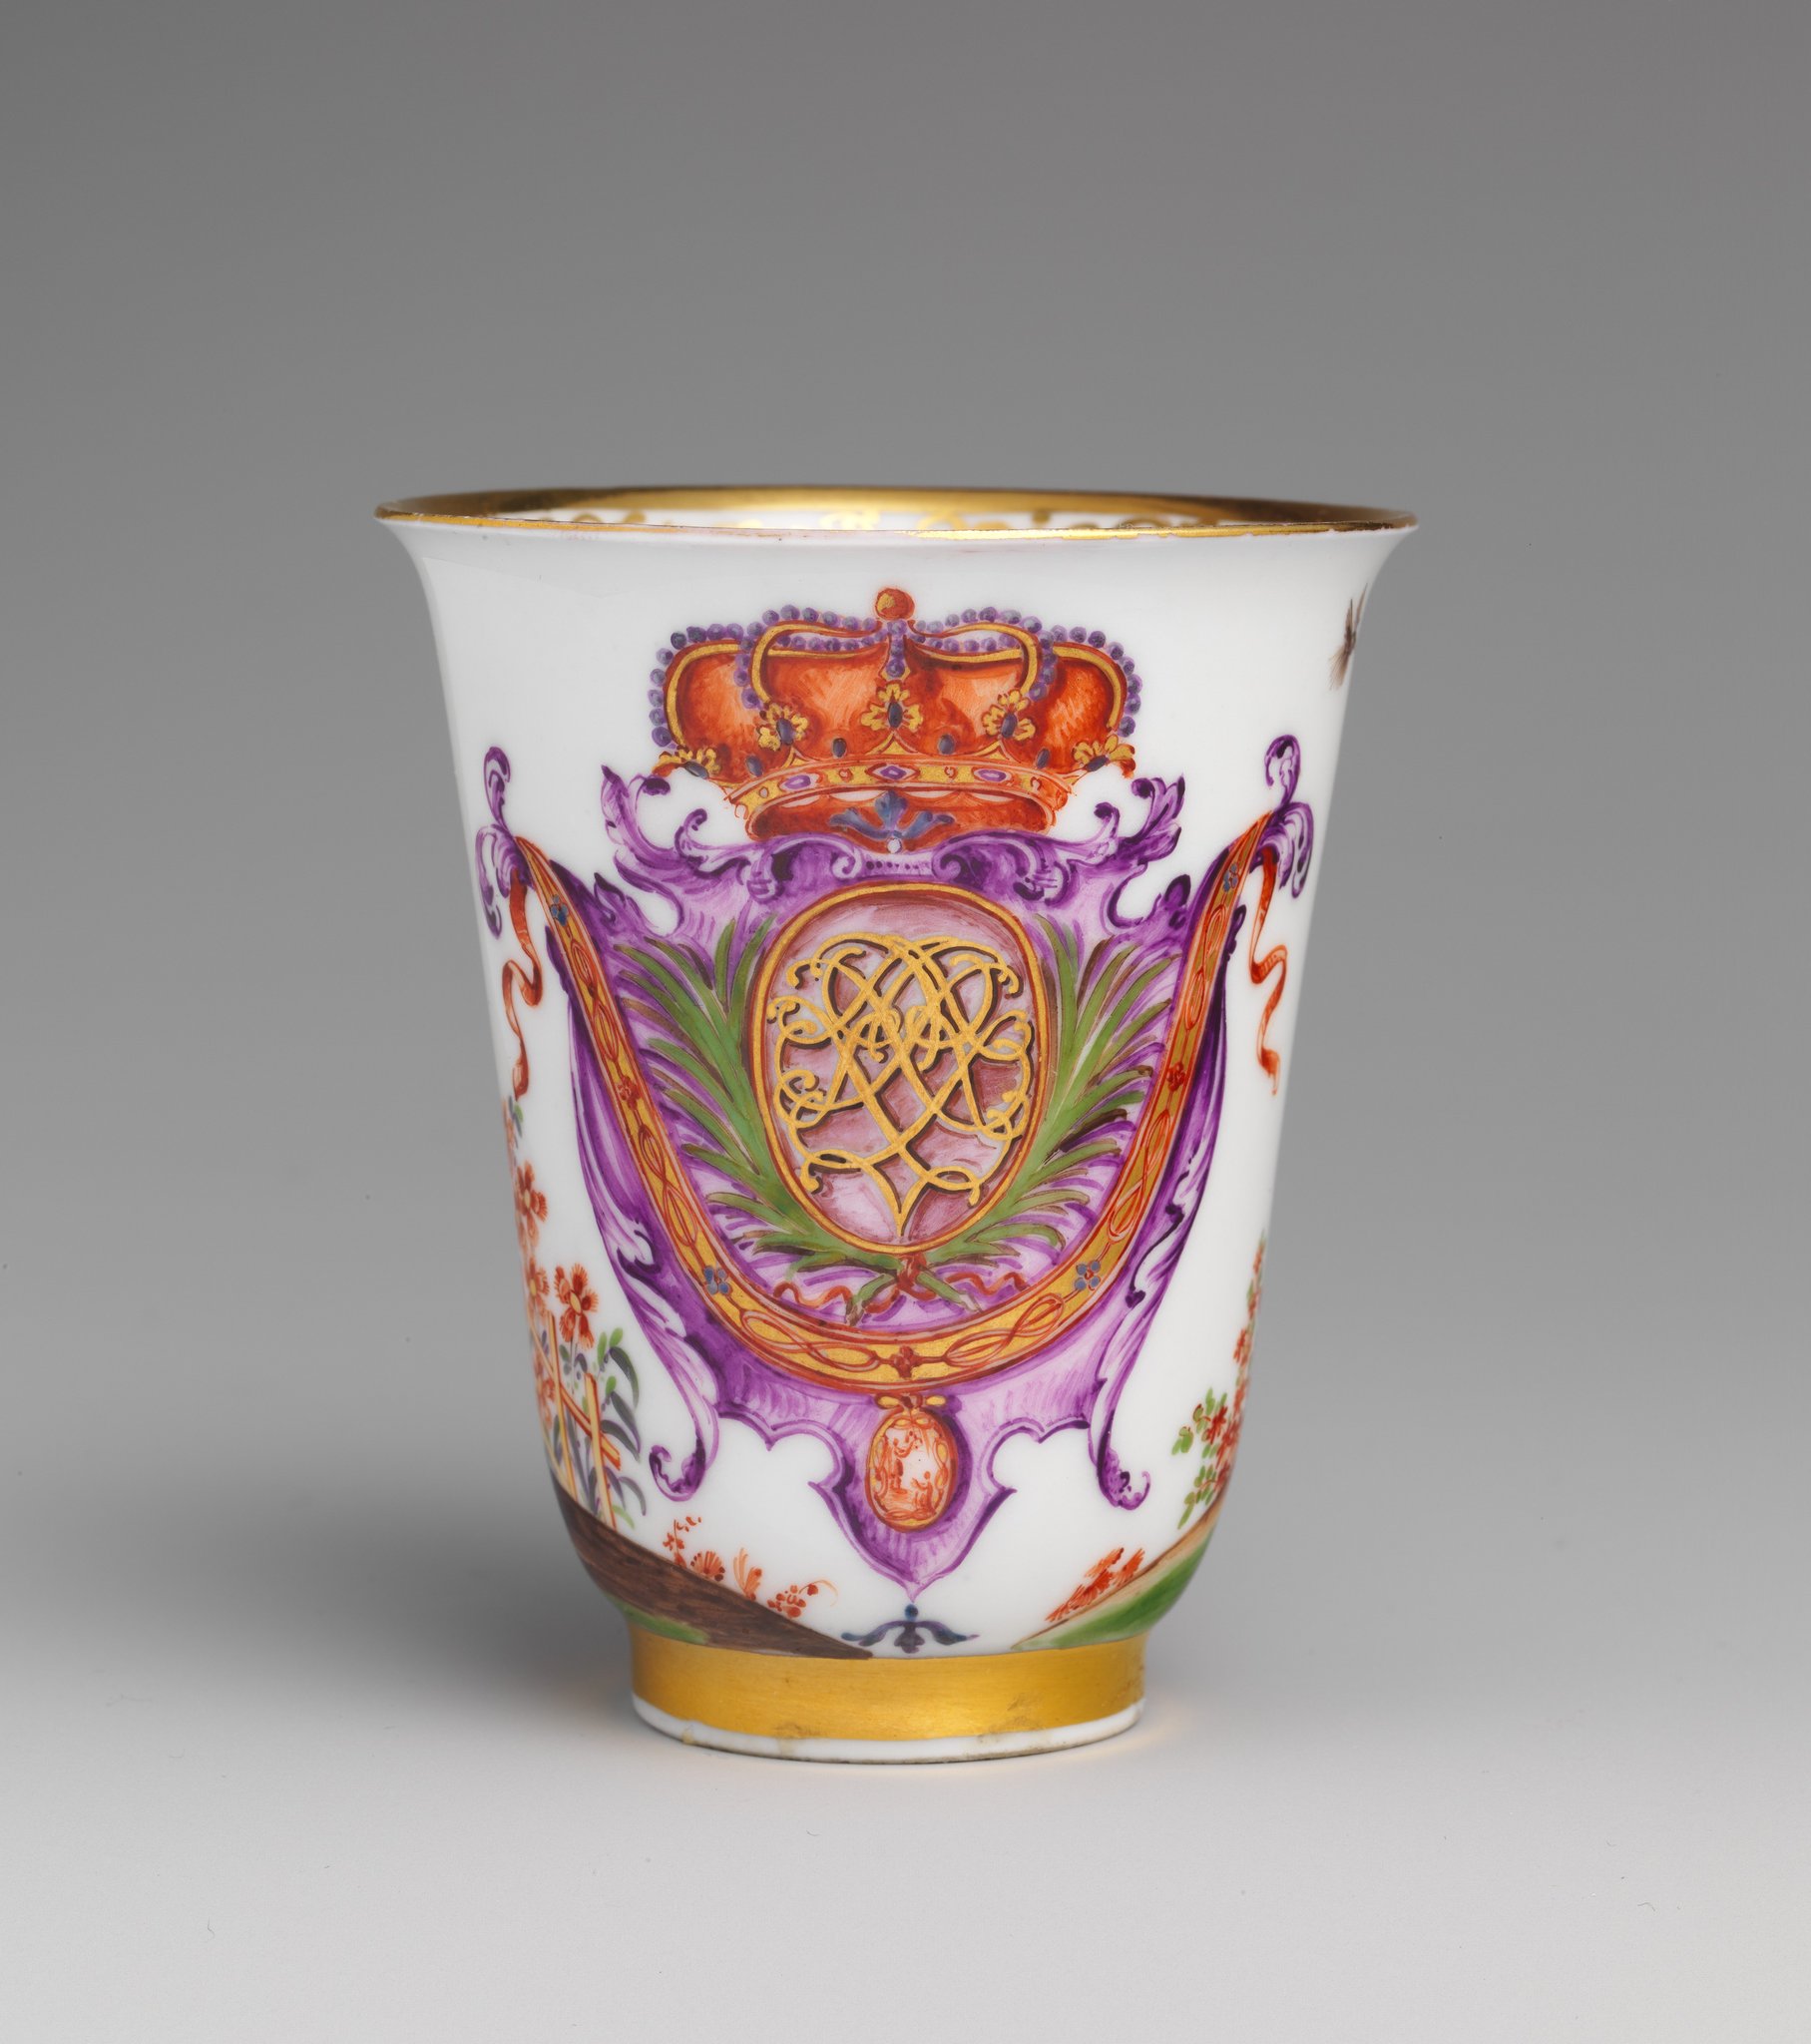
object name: beaker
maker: meissen manufactory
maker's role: manufactory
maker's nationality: german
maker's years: 1710-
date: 1724-1725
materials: enamel, gold, hard paste porcelain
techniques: polychrome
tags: birds,men,coat of arms